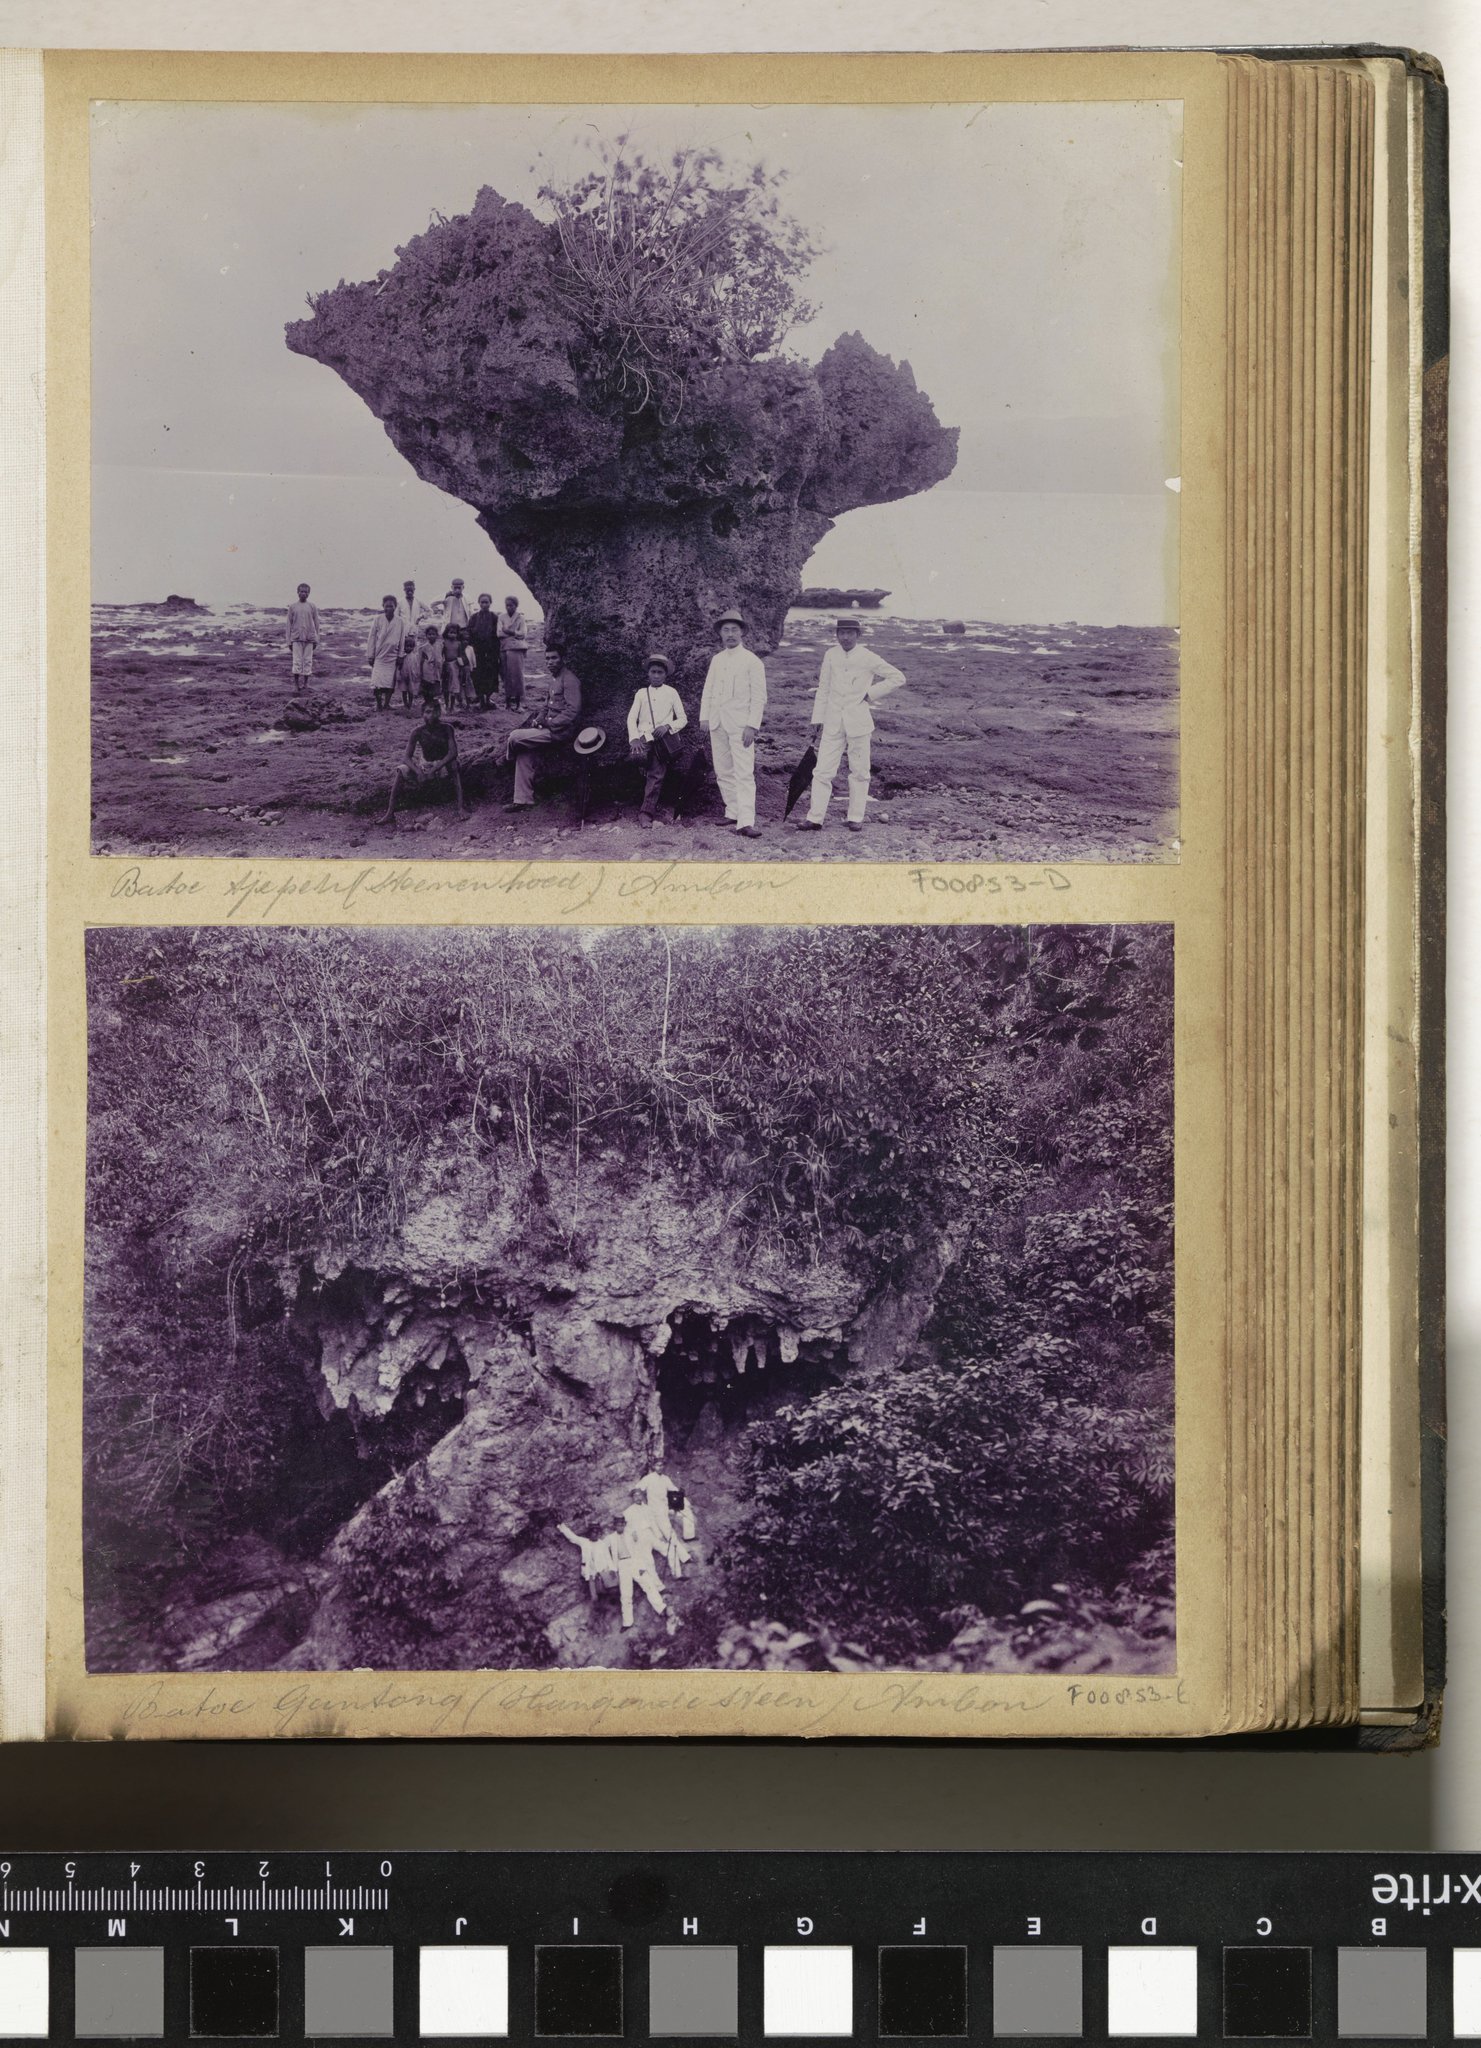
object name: photograph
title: Batoe Gantong (Hangende Steen) Ambon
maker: Anonymous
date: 1900-1920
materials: cardboard, paper, photographic support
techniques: daylight paper print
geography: ambon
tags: tripod, photographer at work - cc - out of doors, rock-formations, dutch east indies, the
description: Onderdeel van Reisalbum met foto's van Ambon.